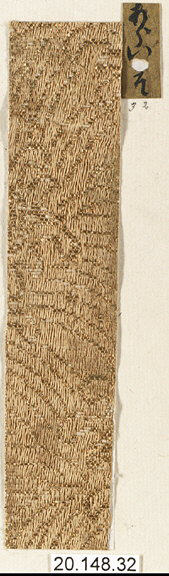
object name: piece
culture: japanese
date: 1501-1600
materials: silk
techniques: compound weave